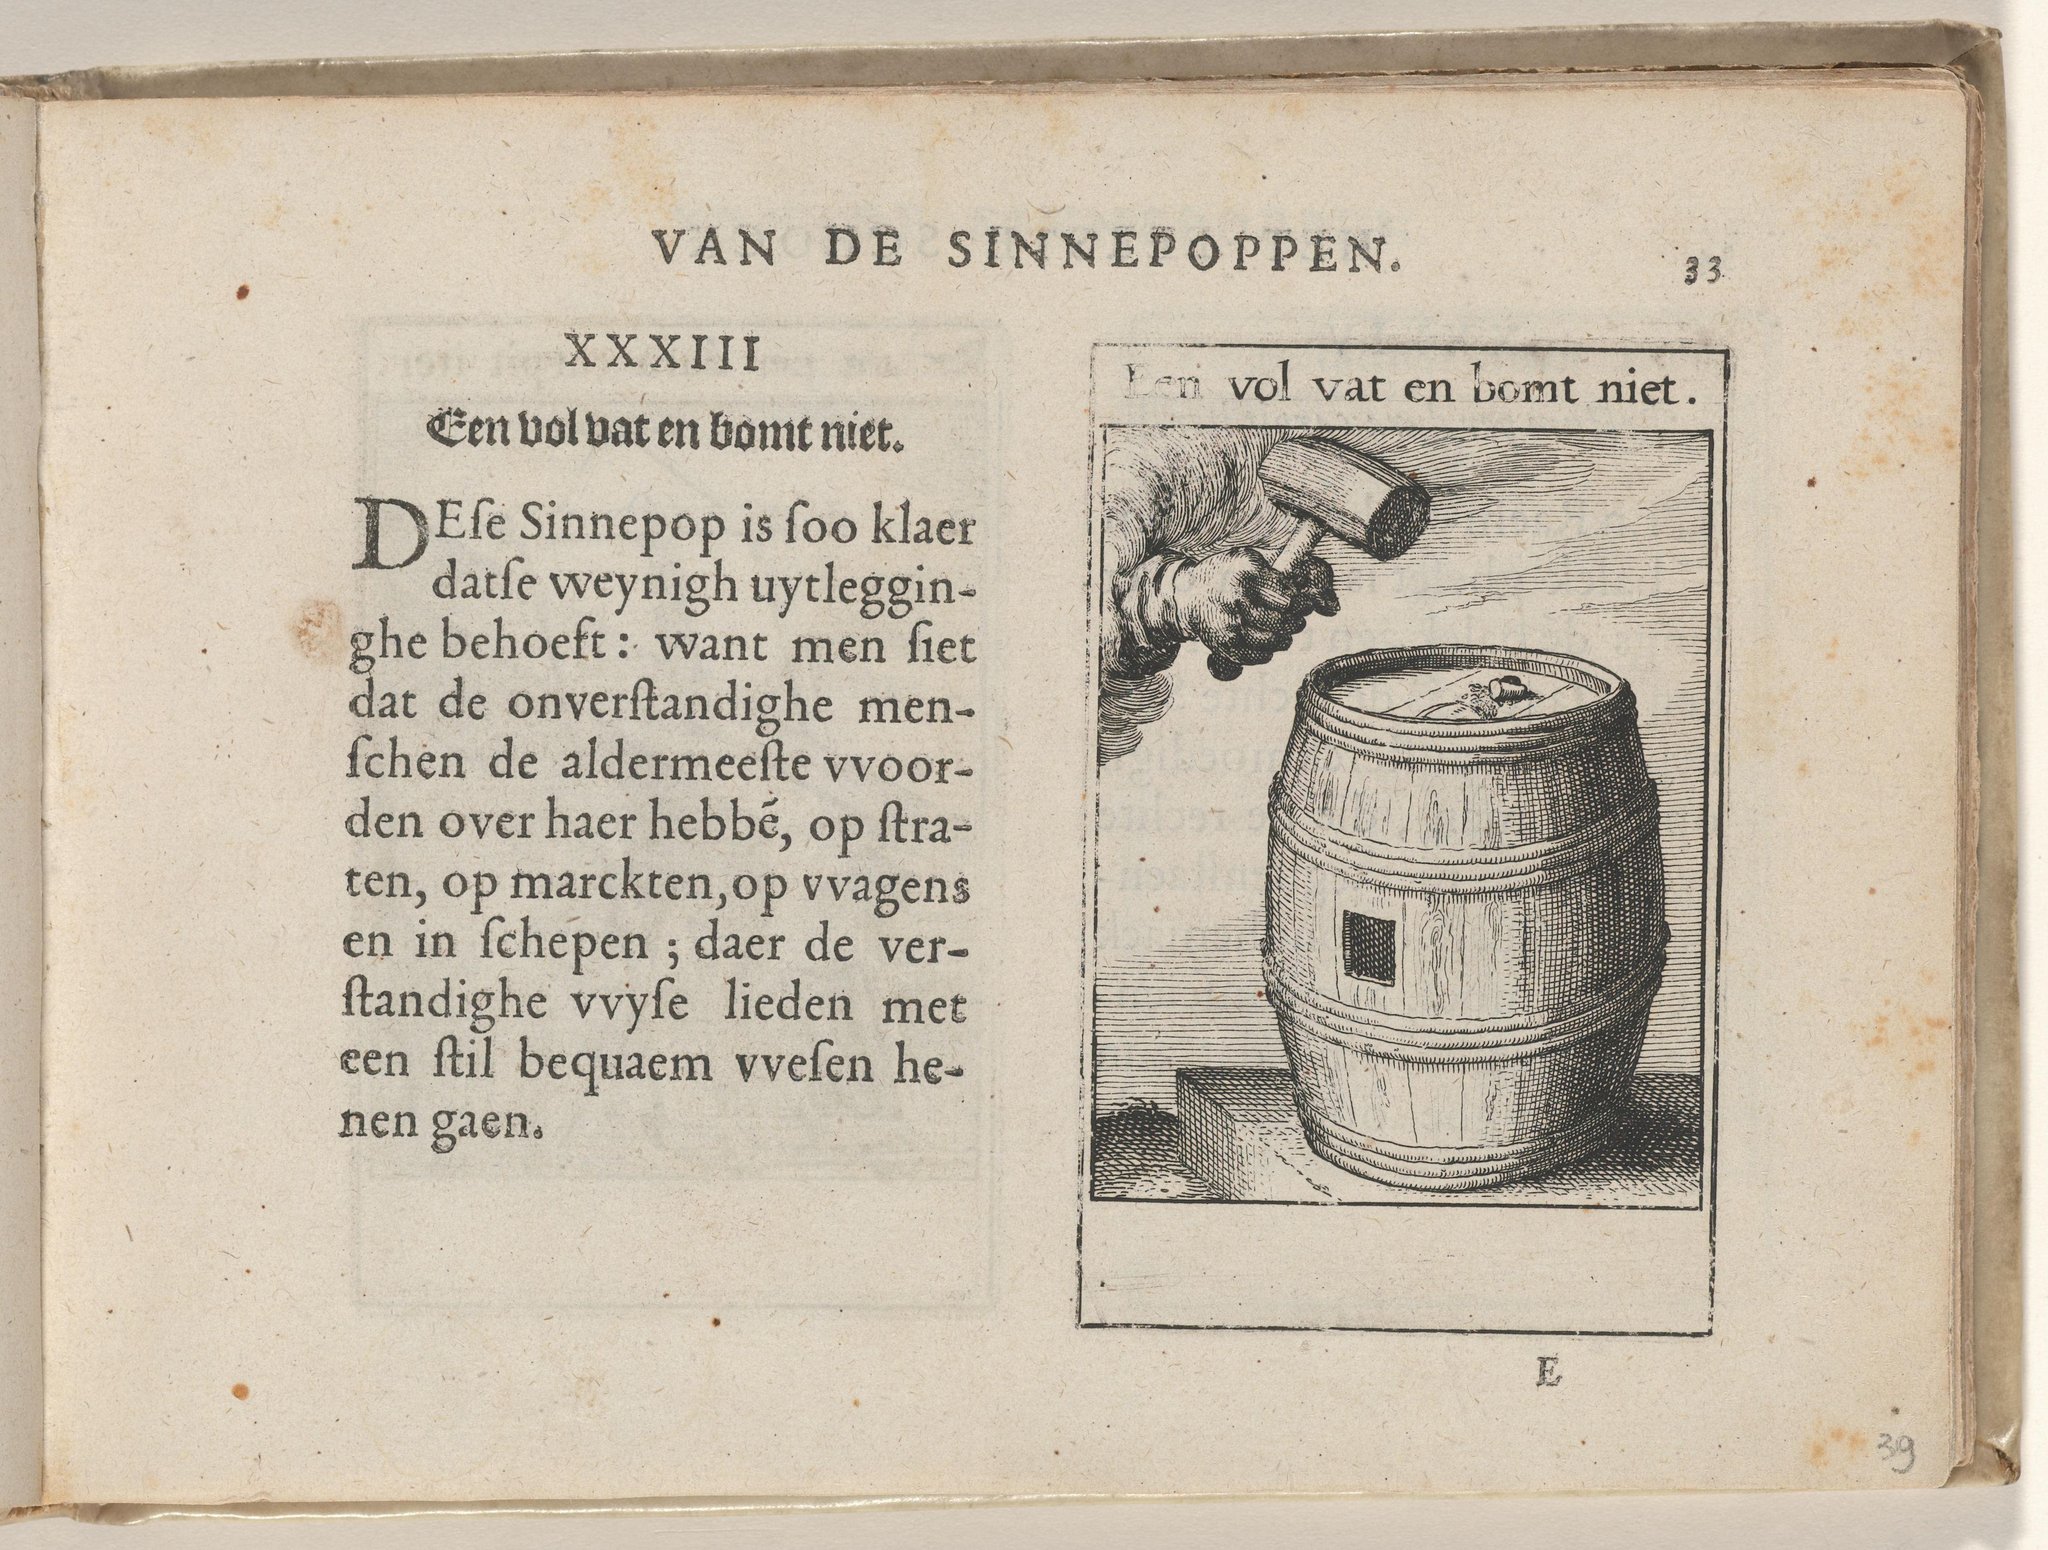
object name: album leaf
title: XXXIII Een vat vol en bomt niet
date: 1614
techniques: engraving, printing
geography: the hague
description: XXXIII Een vat vol en bomt niet. Eerste schok. Onderdeel van 'Sinnepoppen', R. Visscher, 1614.